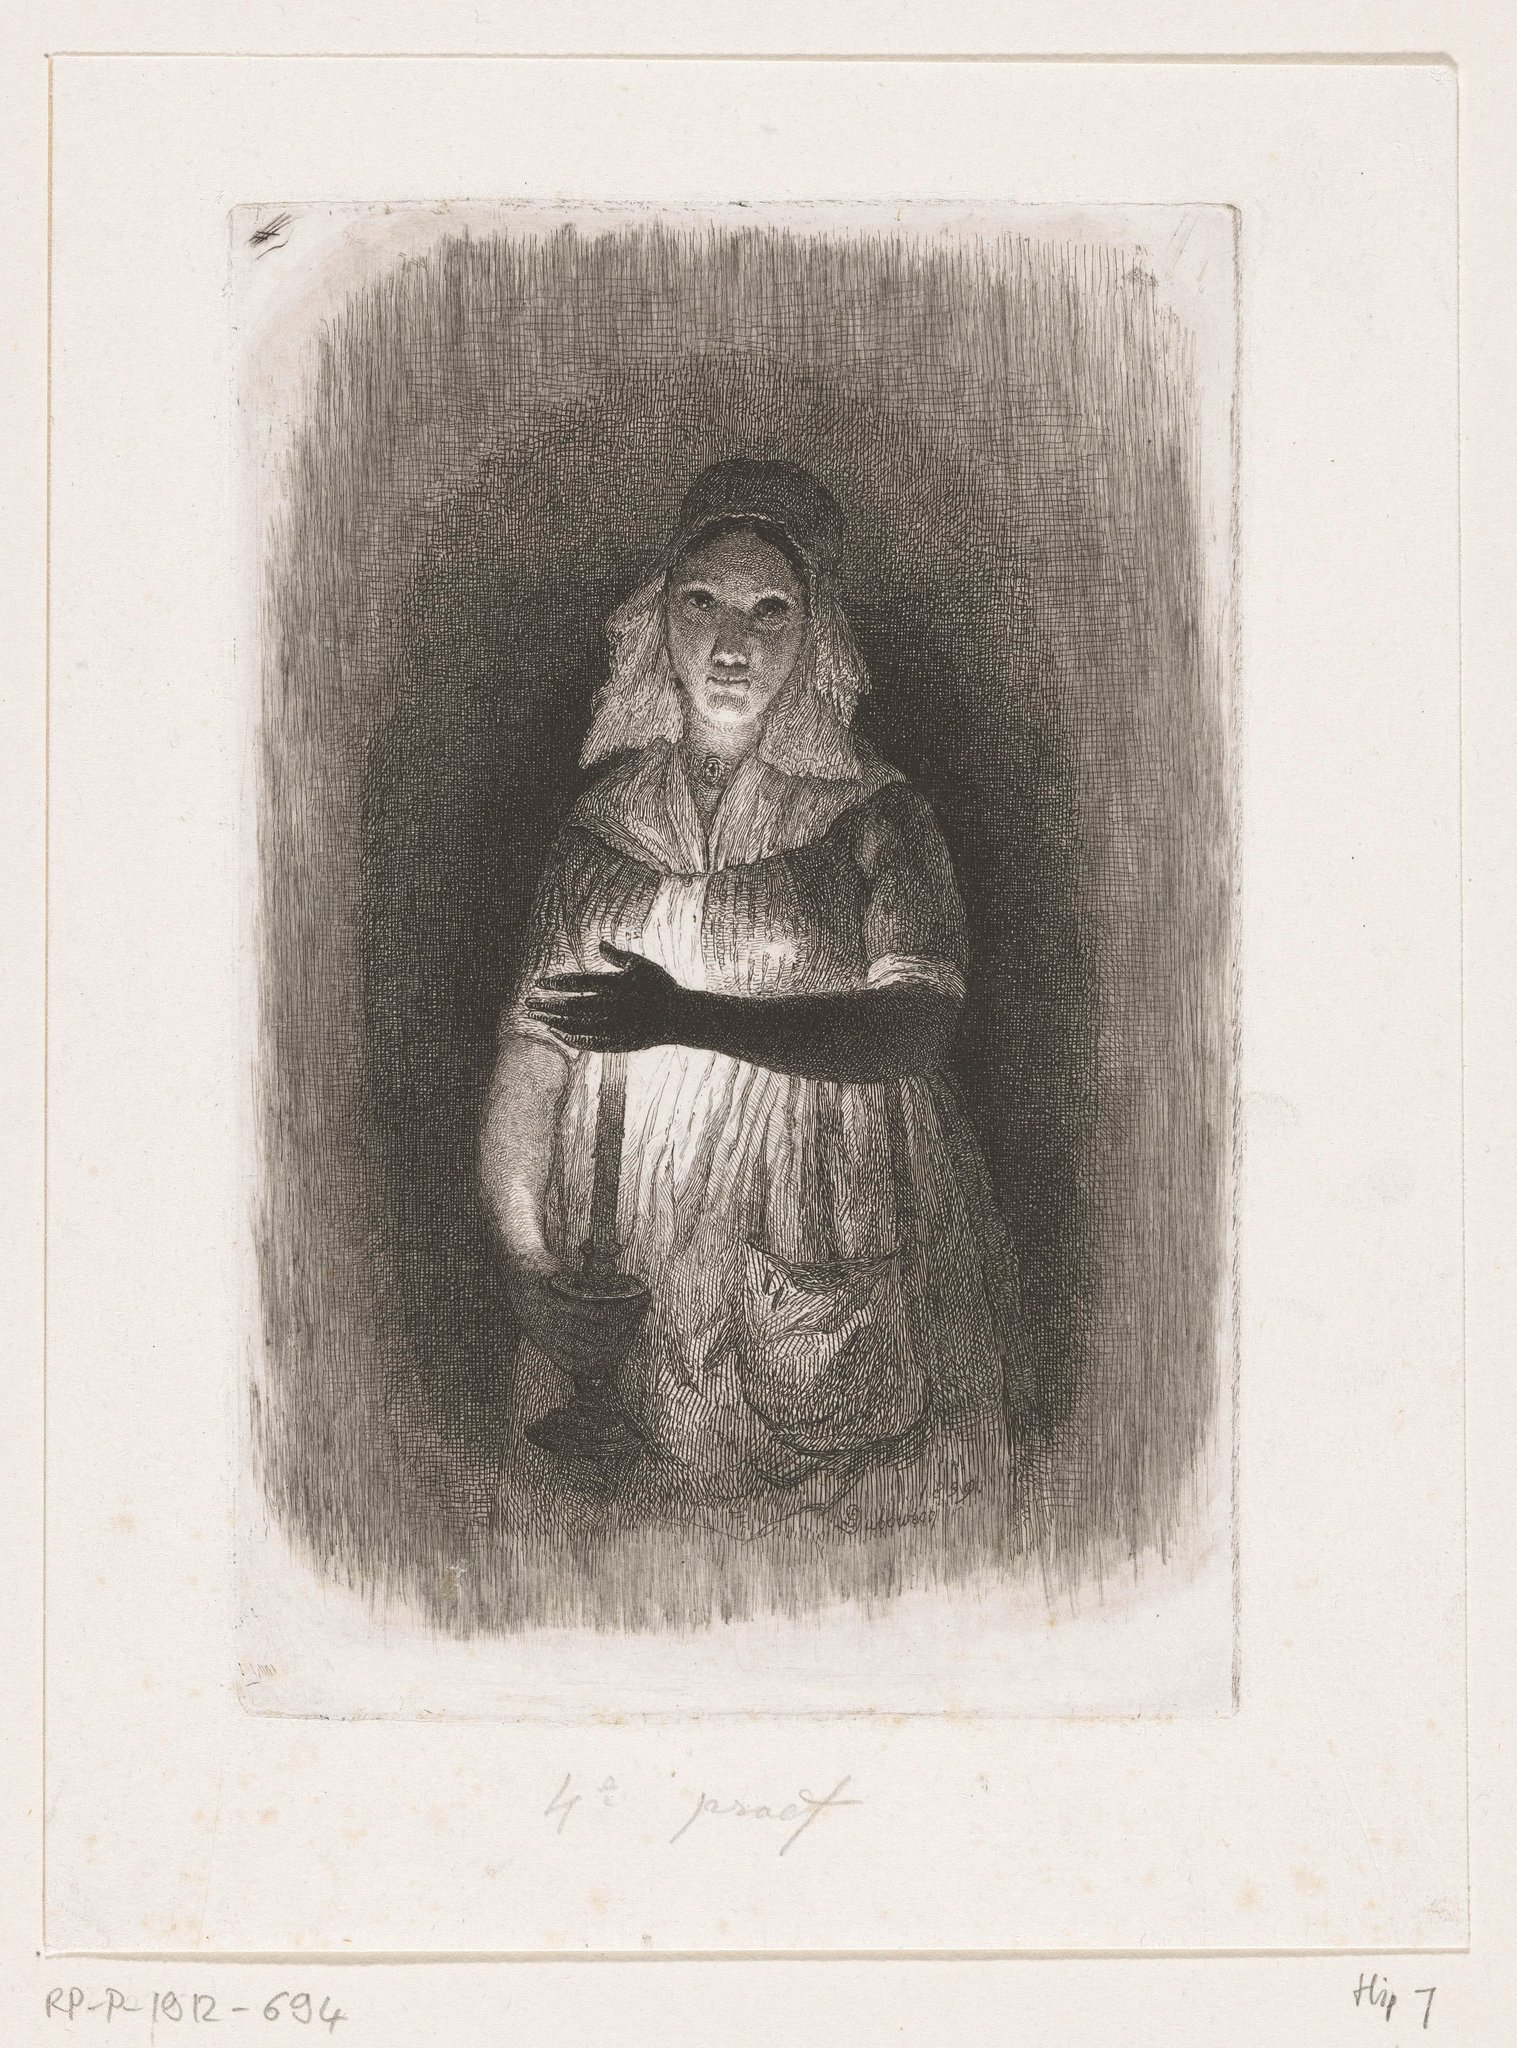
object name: print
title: Vijf etsproeven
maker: pierre louis dubourcq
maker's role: draughtsman, painter, print maker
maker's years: 1815-1873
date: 1839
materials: paper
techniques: drypoint, etching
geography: netherlands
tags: maid ~ house personnel, chandelier, candelabrum (+ kindling a light; lit, burning light, lamp, candle)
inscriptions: collector's mark: Lugt 2228